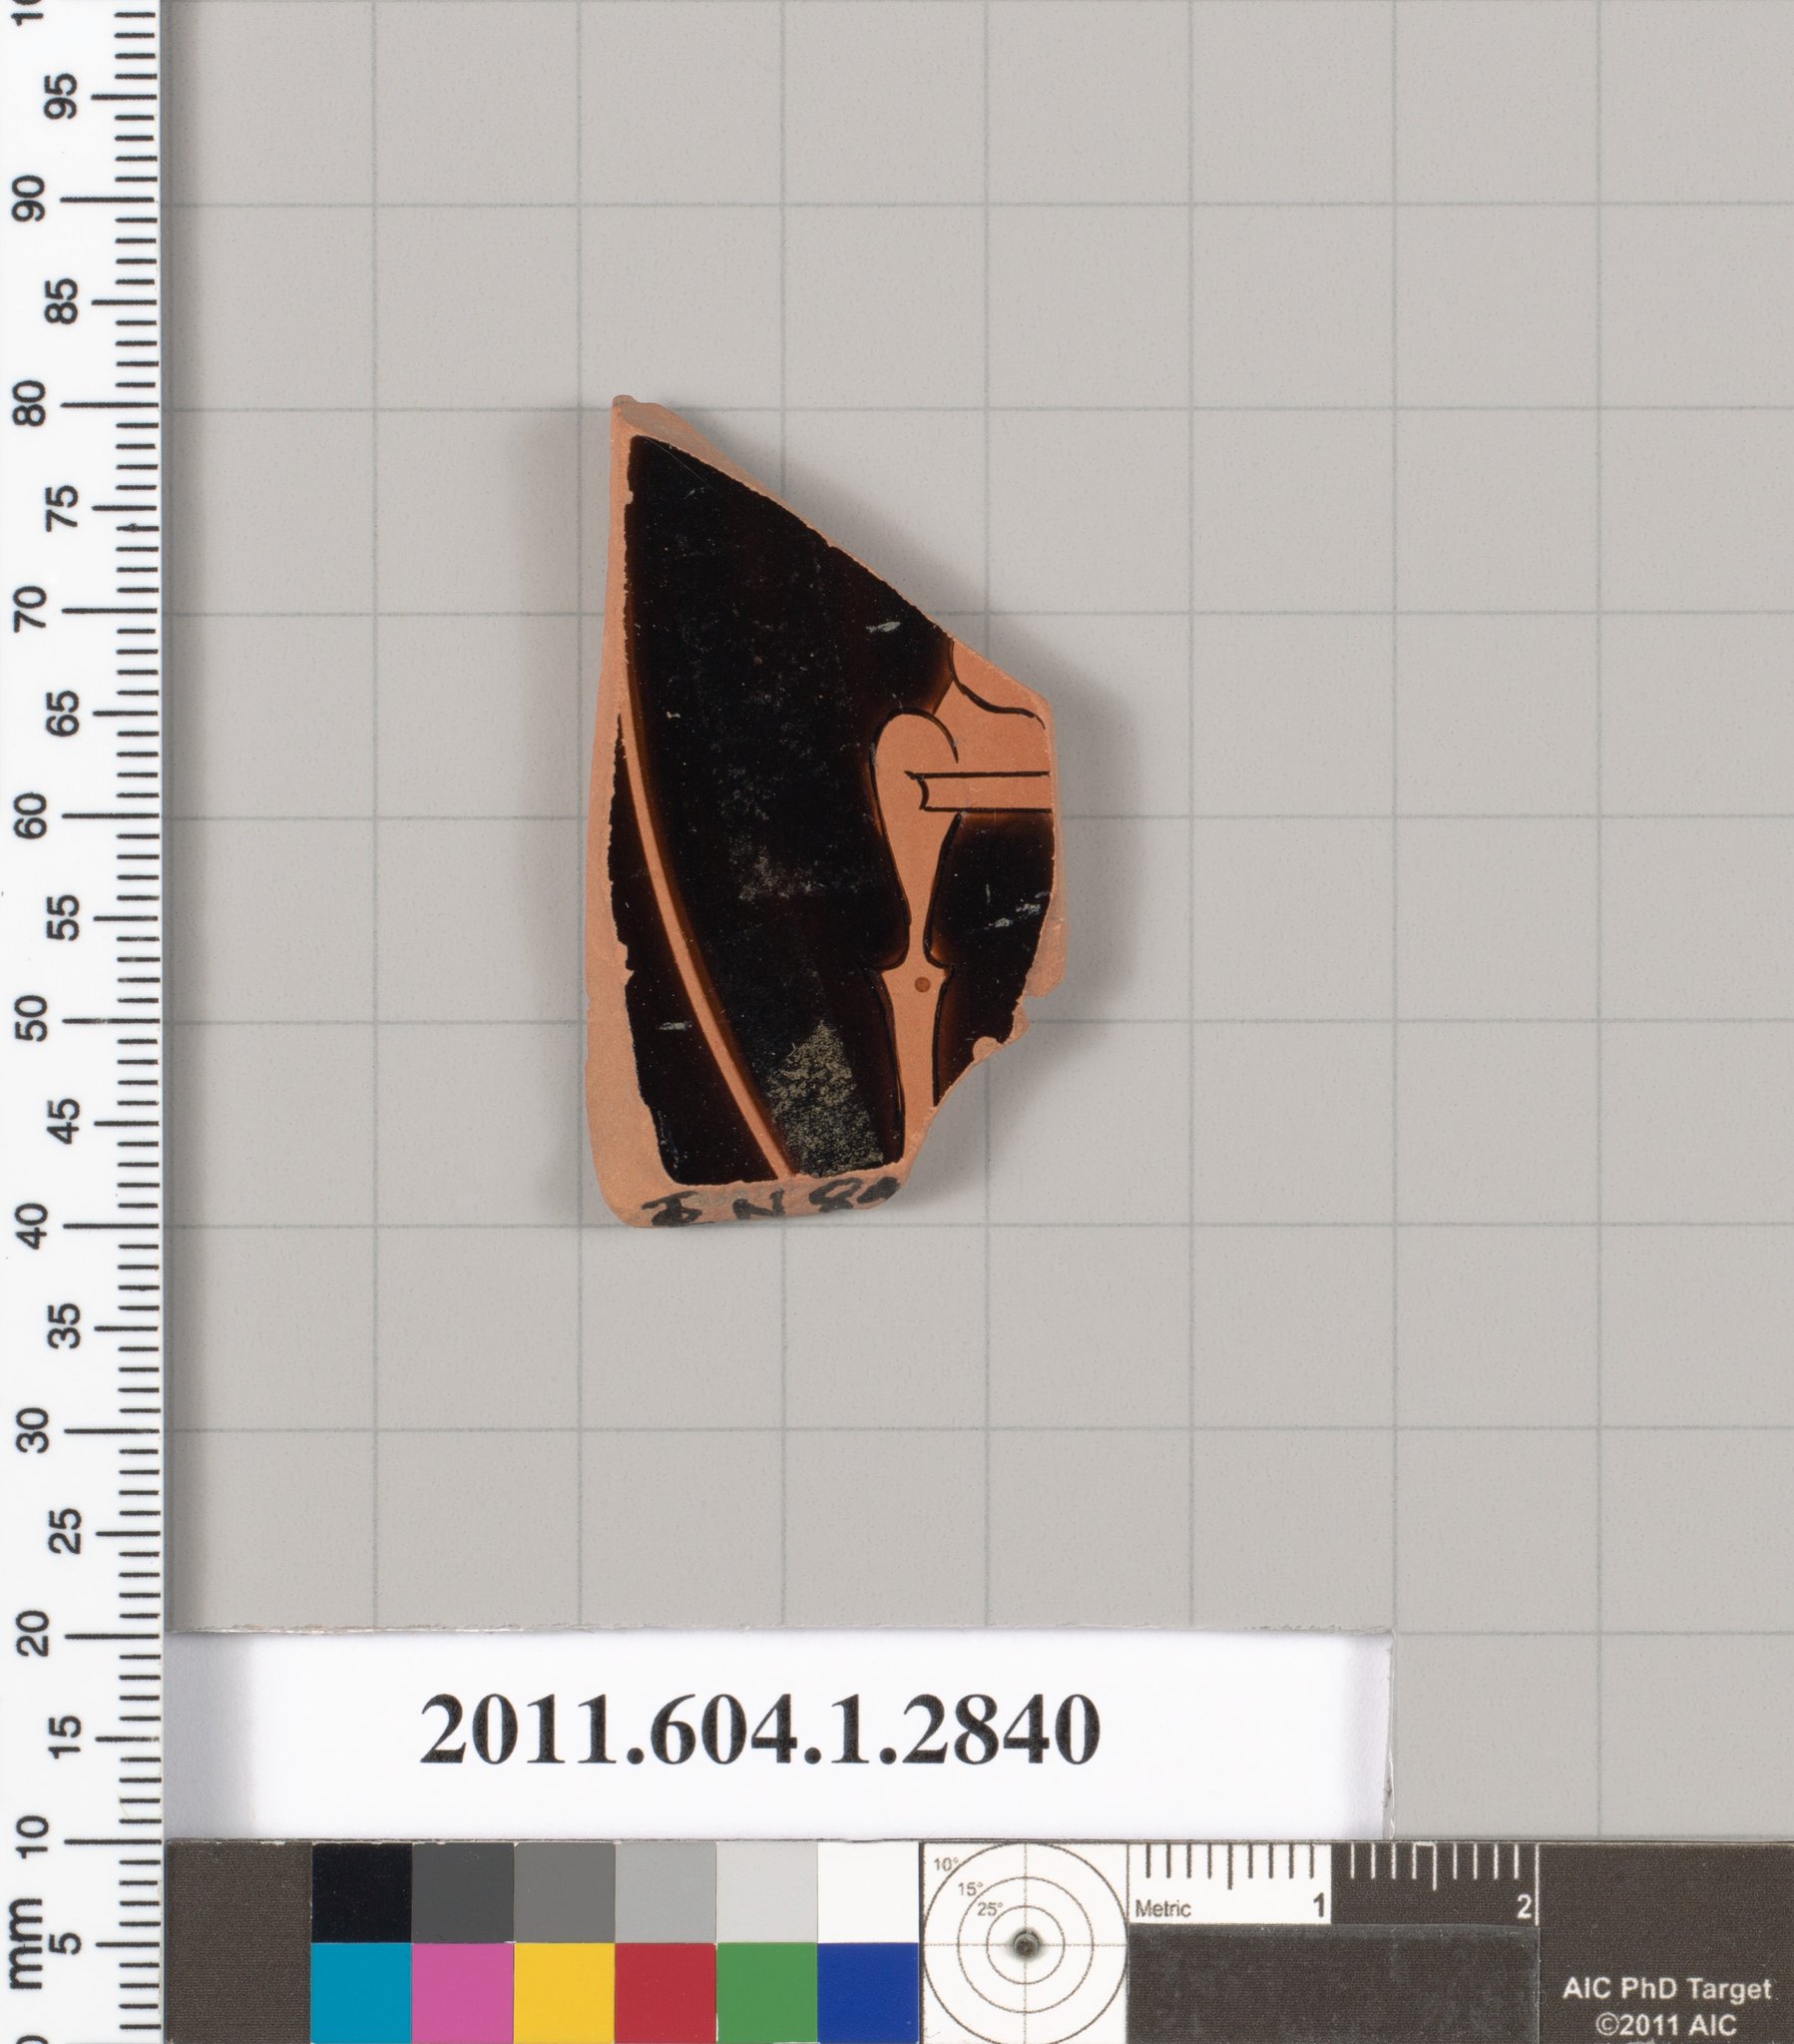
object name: kylix fragment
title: Terracotta fragment of a kylix (drinking cup)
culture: greek, attic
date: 500-490 BCE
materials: terracotta